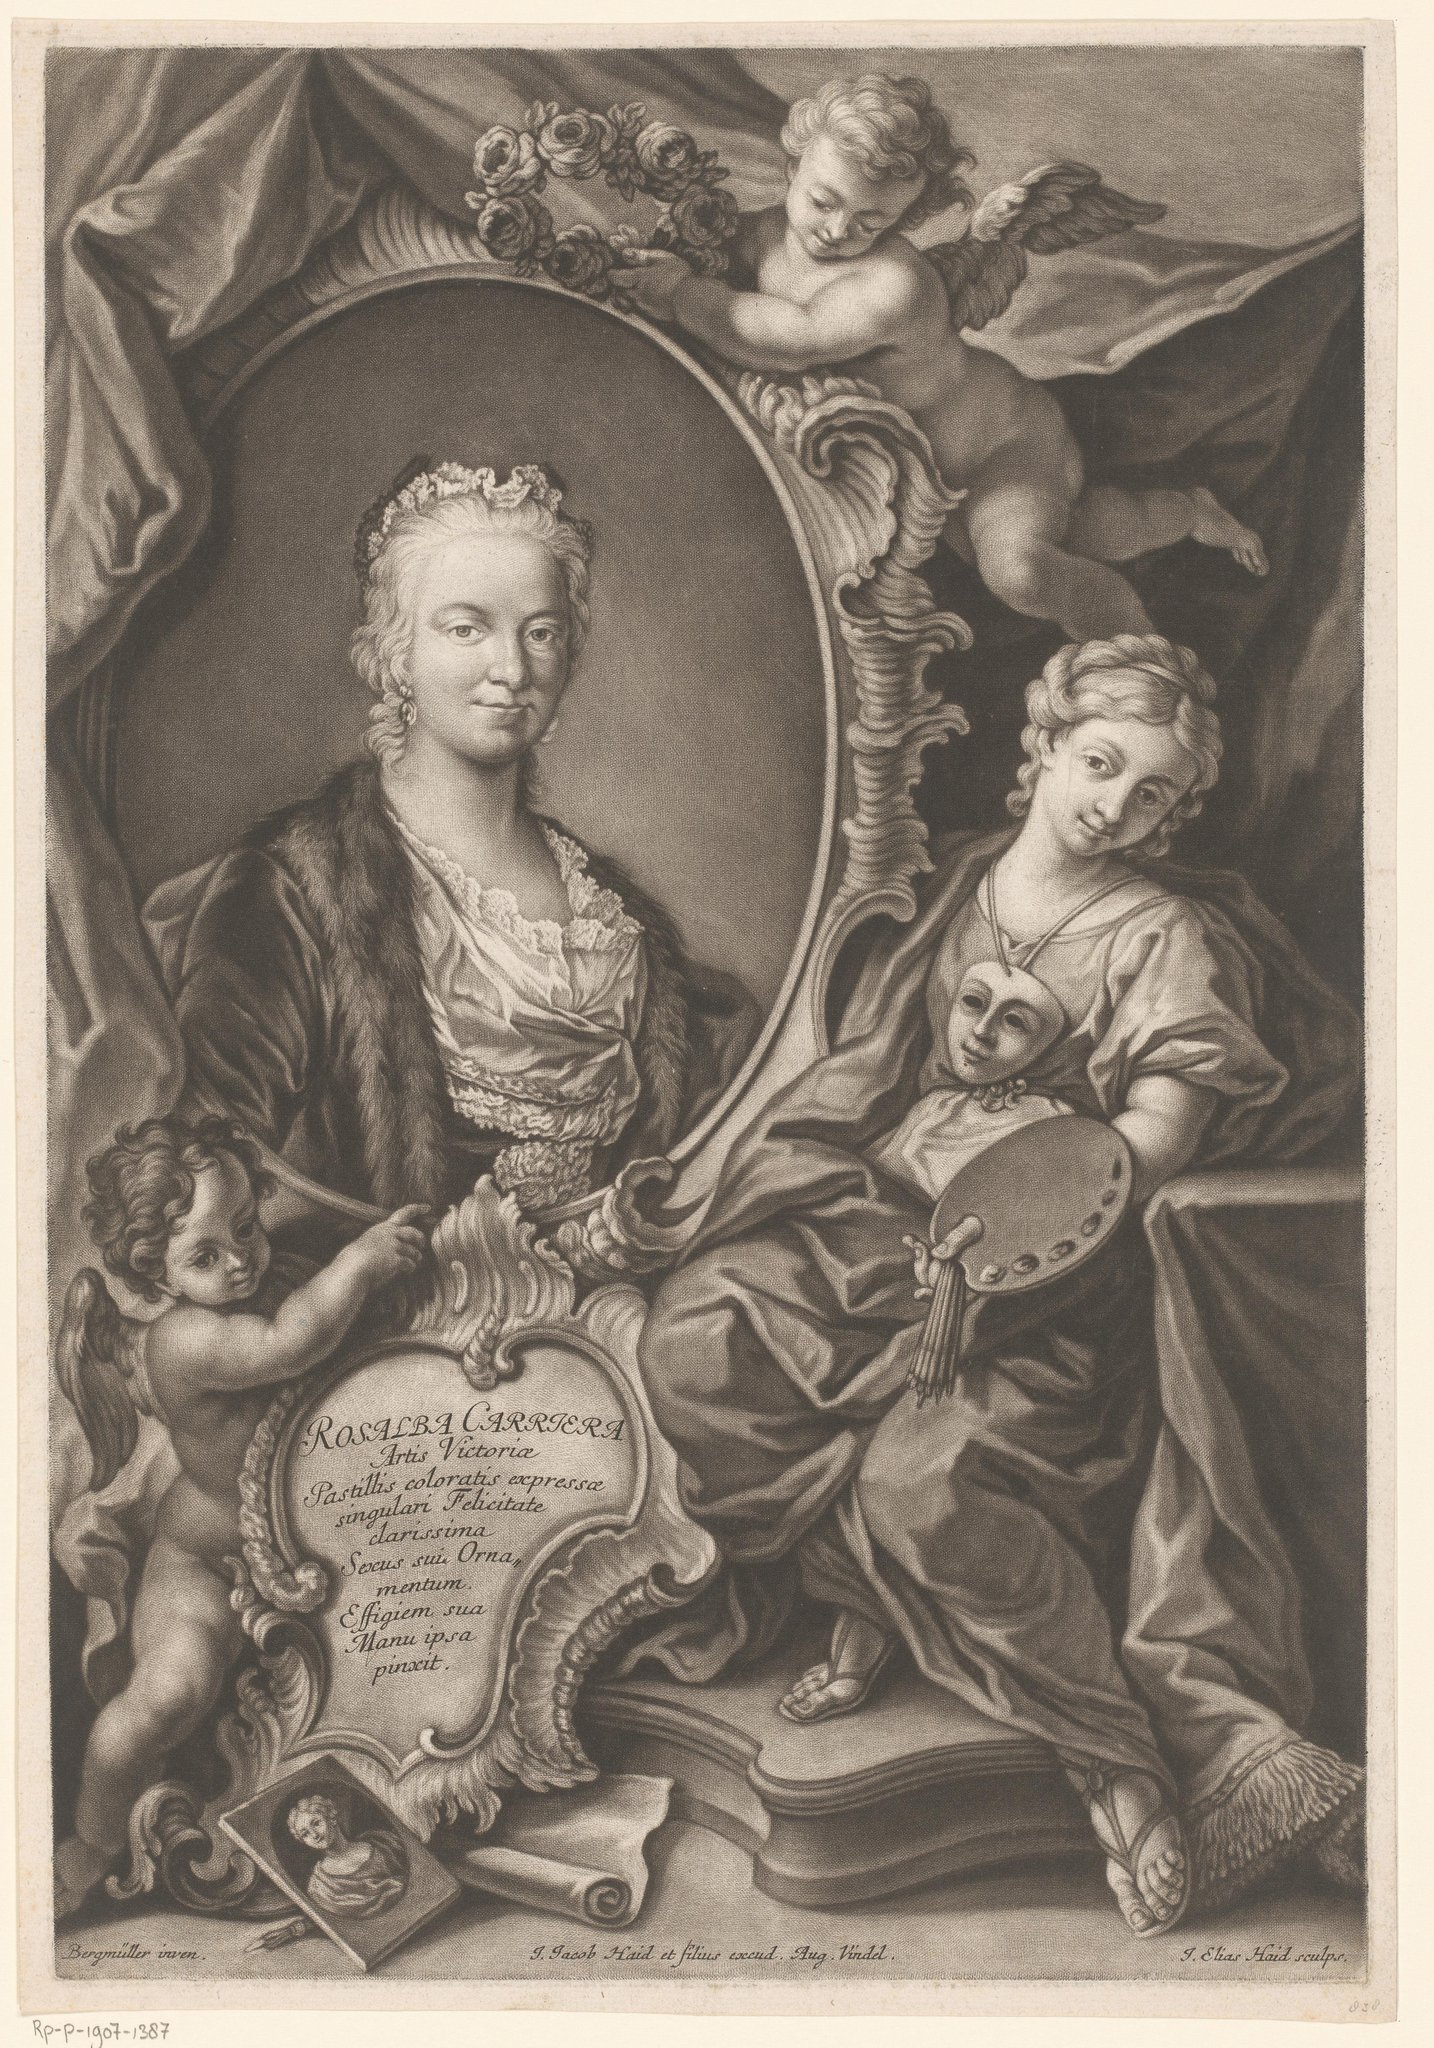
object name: print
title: Portret van Rosalba Carriera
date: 1757-1809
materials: paper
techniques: mezzotint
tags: venice, draughtsman, rosalba carriera, historical persons - bb - woman, writing tools, ornament ~ cartouche, symbolic representations, allegories and emblems ~ art; 'arte' (ripa), cupids: 'amores', 'amoretti', 'putti'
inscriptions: collector's mark: Lugt 2228